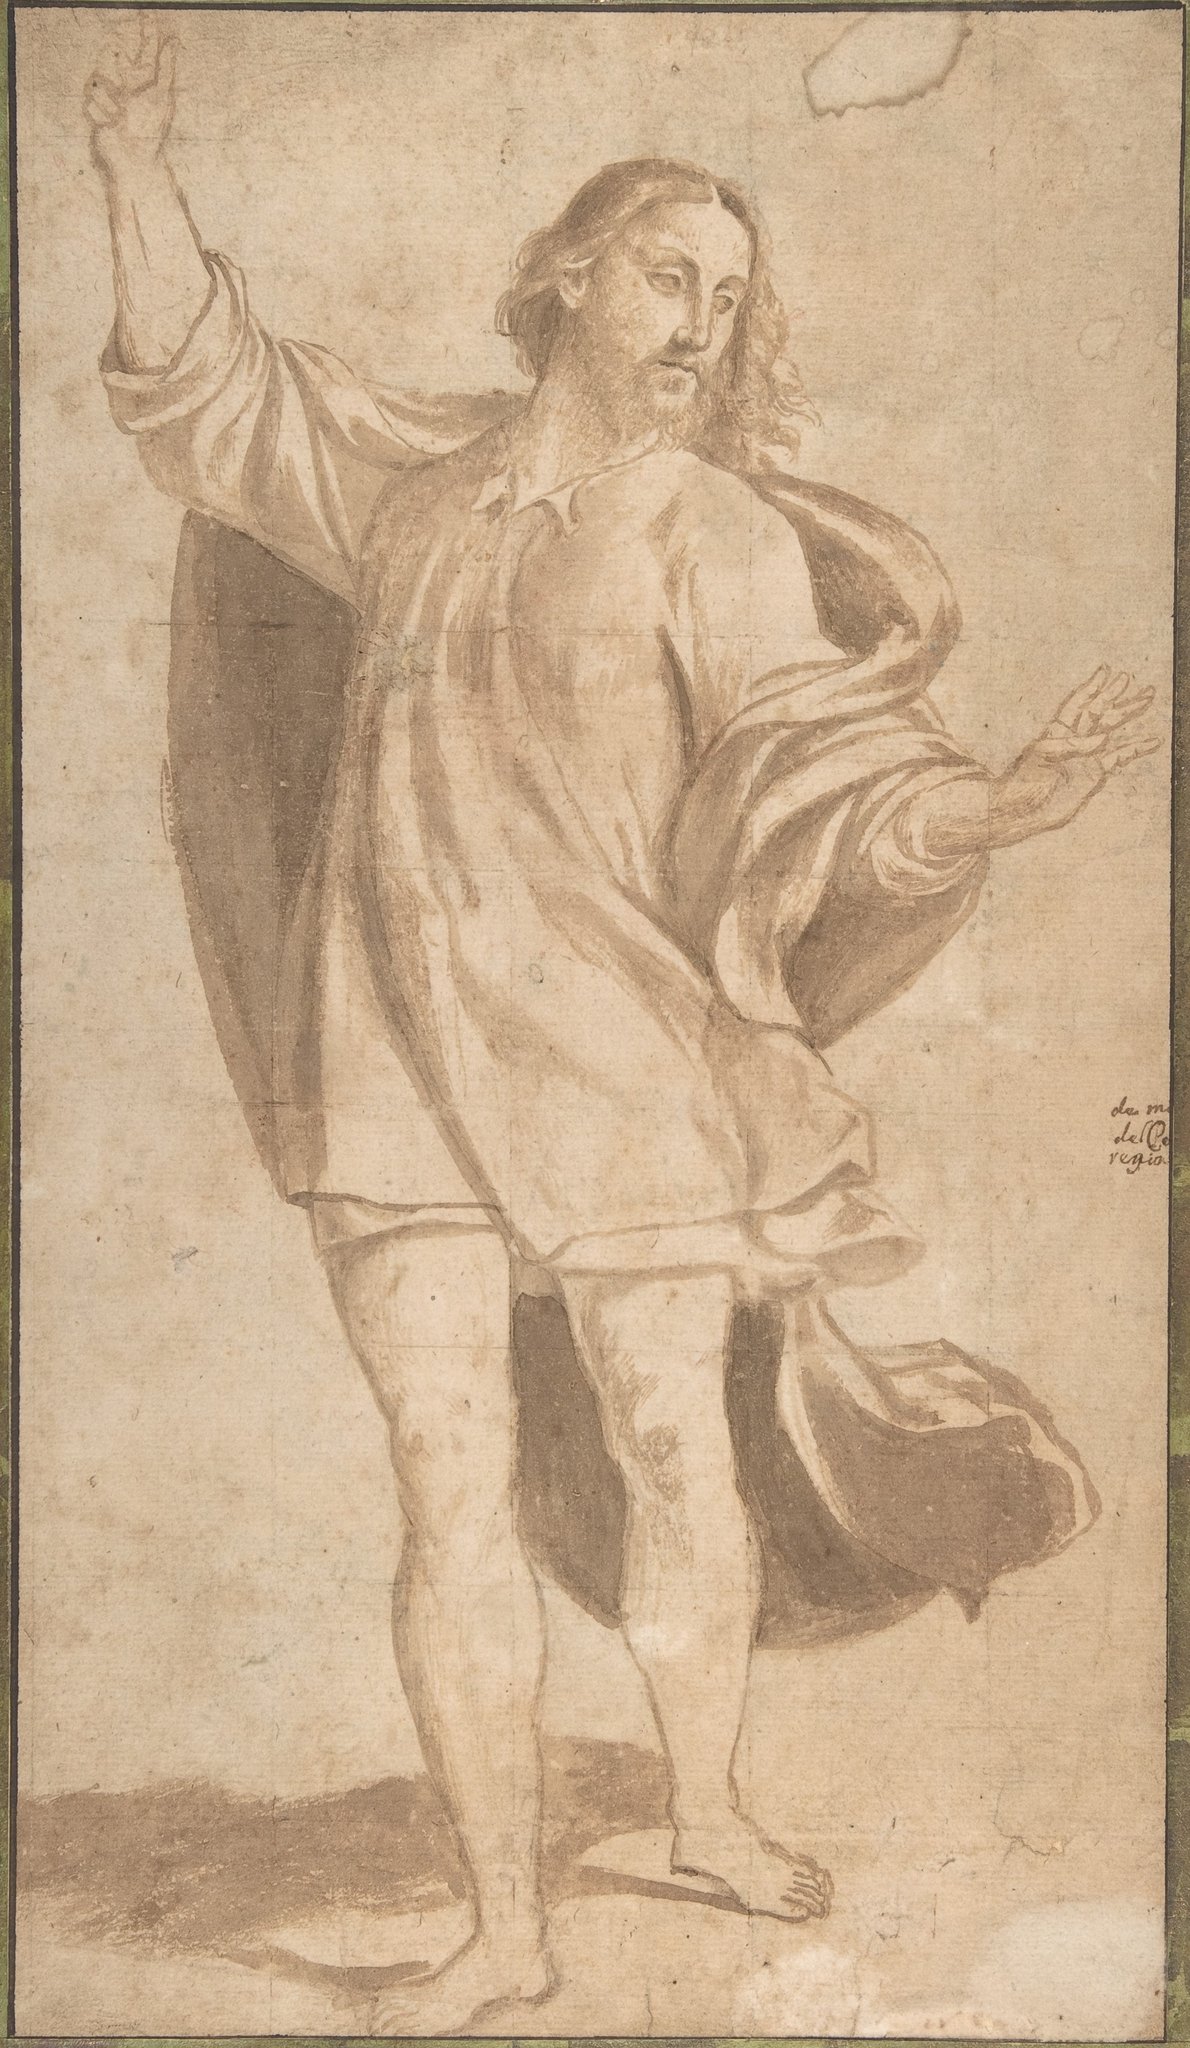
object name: drawing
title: Standing Figure of Christ with Arms Upraised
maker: giovanni antonio da pordenone (giovanni antonio de sacchis)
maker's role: artist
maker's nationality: italian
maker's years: 1483-1539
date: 1484-1539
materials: charcoal, paper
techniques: brush, drawing, wash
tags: christ